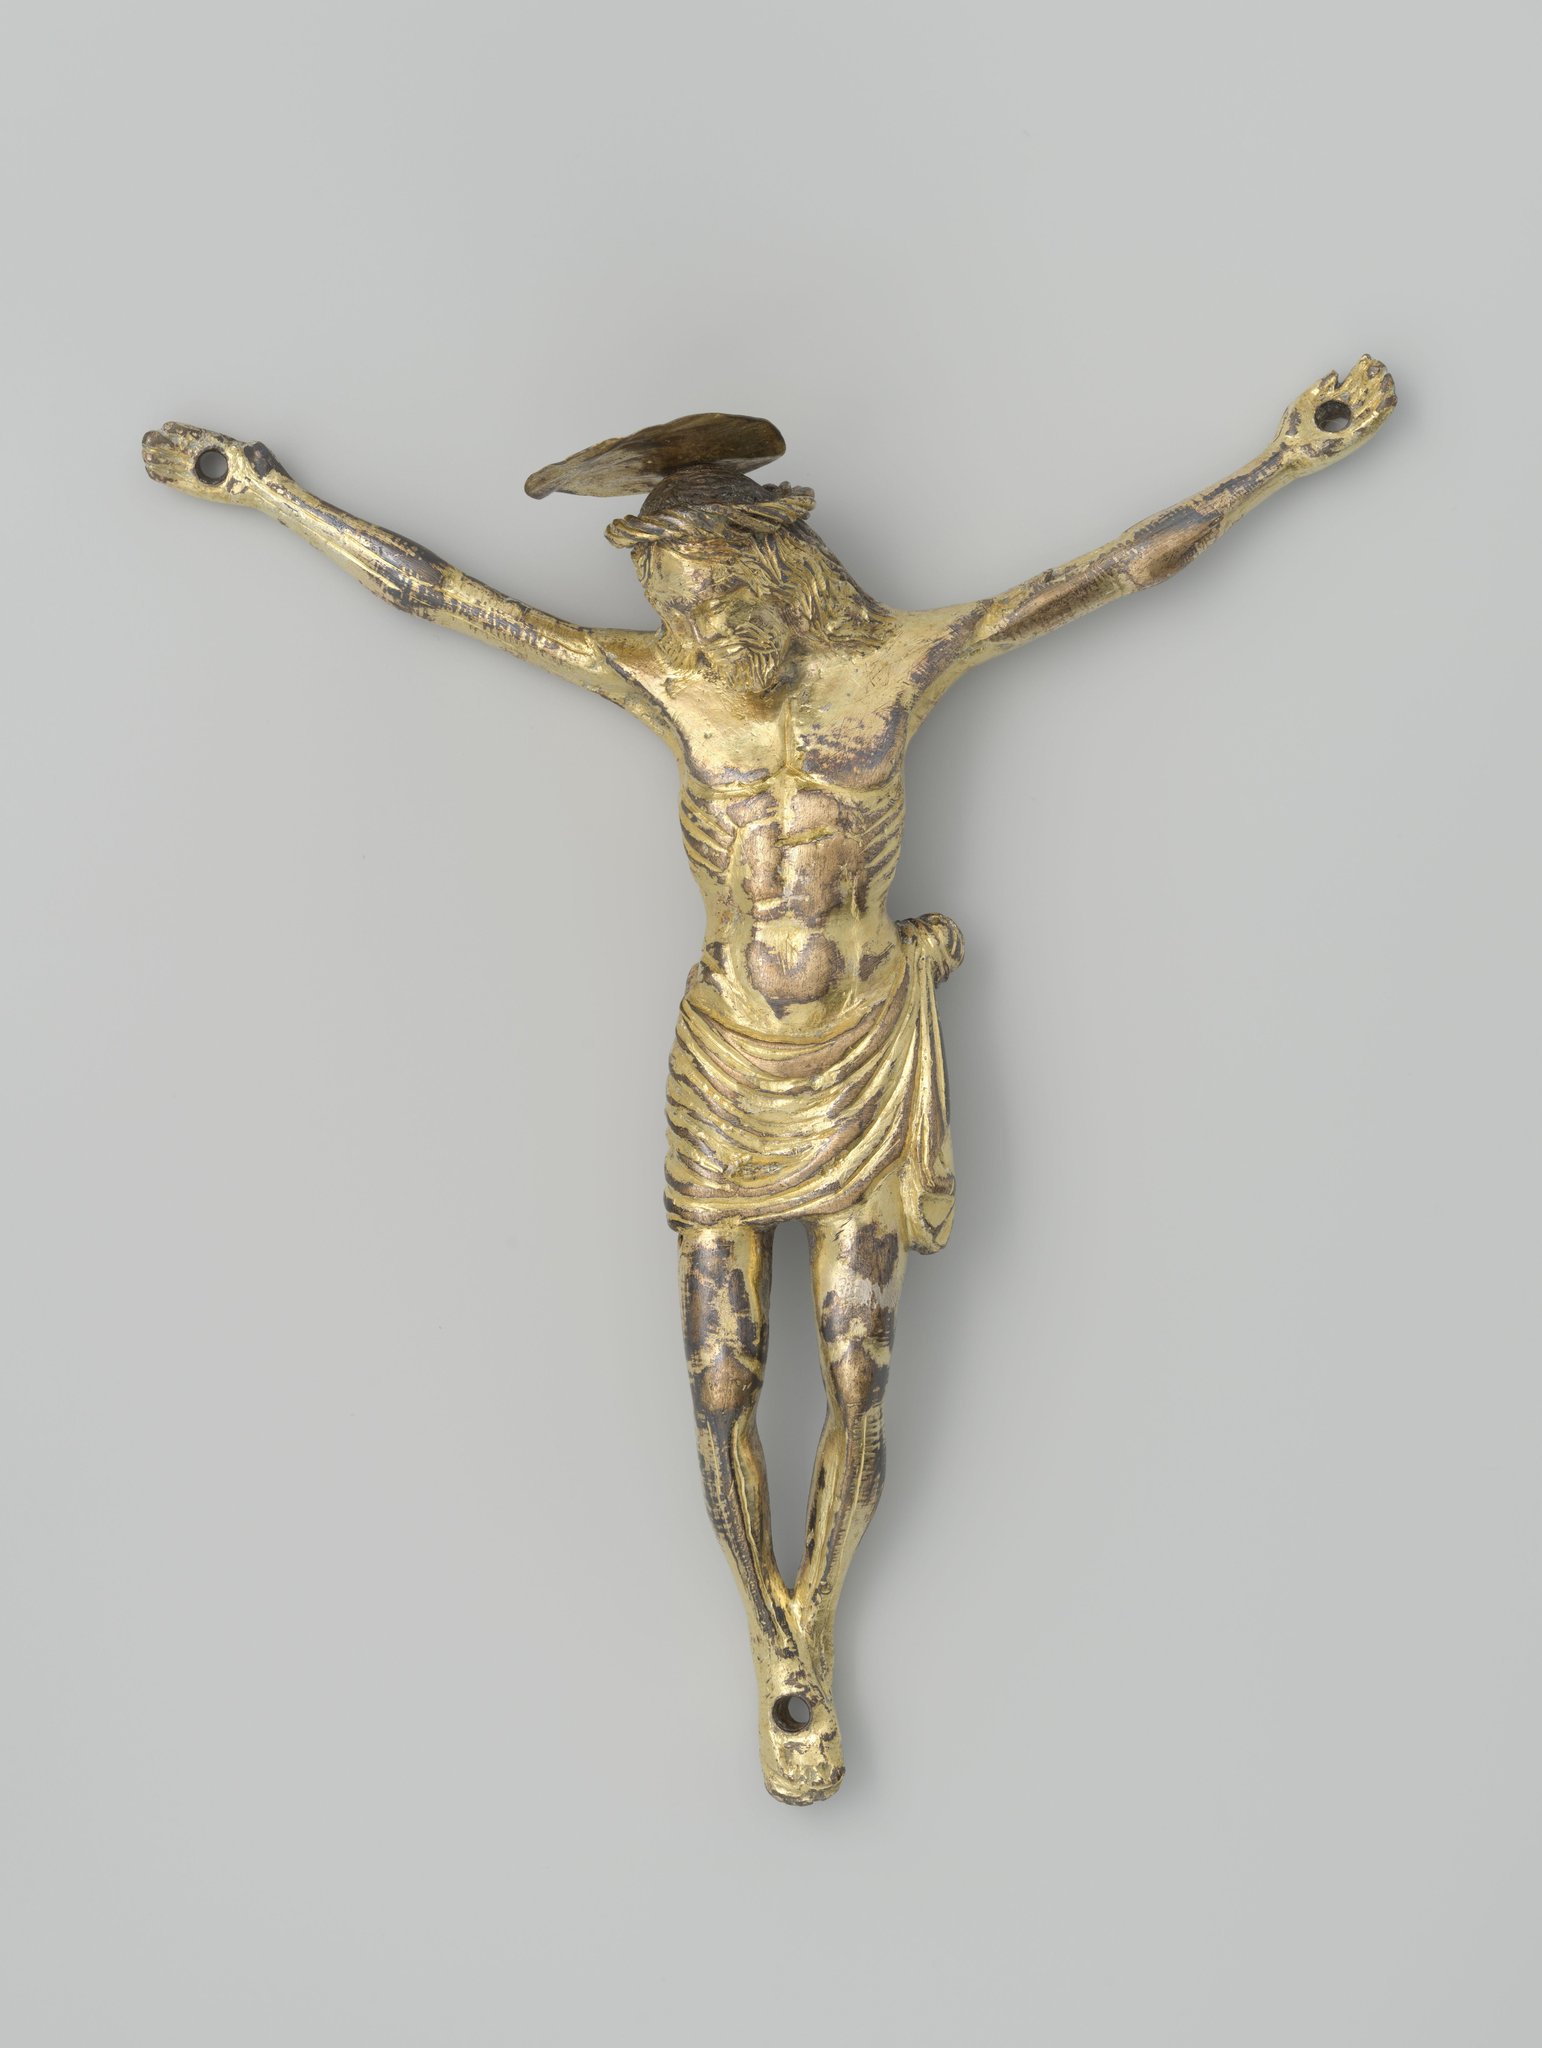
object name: figure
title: Corpus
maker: Anonymous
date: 1500-1550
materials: bronze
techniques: casting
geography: northern italy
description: Stilistisch sluit dit kleine kruisbeeld, dat oorspronkelijk voor privédevotie of voor een klein altaarkruis werd gemaakt, aan bij enkele Italiaanse corpora uit de vroege 16de eeuw. Karakteristiek zijn de scherpe en vrij schematische lichaamsweergave en het haast grafische plooischema van de lendendoek. Een overtuigende vergelijking kan worden gemaakt met twee wat grotere, aan Severo Calzetta, bijgenaamd ‘Severo da Ravenna’ (werkzaam 1496- voor 1538) uit Padua en Ravenna, toegeschreven corpora in het Bodemuseum in Berlijn (inv. 7242, zie Volker Krahn, Bronzetti veneziani. Die venezianischen Kleinbronzen der Renaissance aus dem Bode-Museum Berlin, Berlijn 2003, no. 45) en in Cleveland, Museum of Art (Krahn 2003, p. 177). Afgezien van de overeenkomstige houding en proporties treft de sterke overeenkomst met de lendendoek en met de tulbandvormige, gewonden doornenkroon van het brons in Cleveland. Een knielende Hieronymus, eveneens aan Severo toegeschreven (Royal Ontario Museum, Toronto, inv. ROM 961.48.1, zie K. Corey Keeble, European bronzes in the Royal Ontario Museum, Toronto 1982, no. 17) bezit een verwante, schijfvormige halo. Op grond van zulke overeenkomsten kan het oorspronkelijke model, waardoor het hier voorgestelde beeldje werd geïnspireerd, worden toegeschreven aan een kunstenaar uit de wereld van Severo in Padua in de eerste decennia van de 16de eeuw.